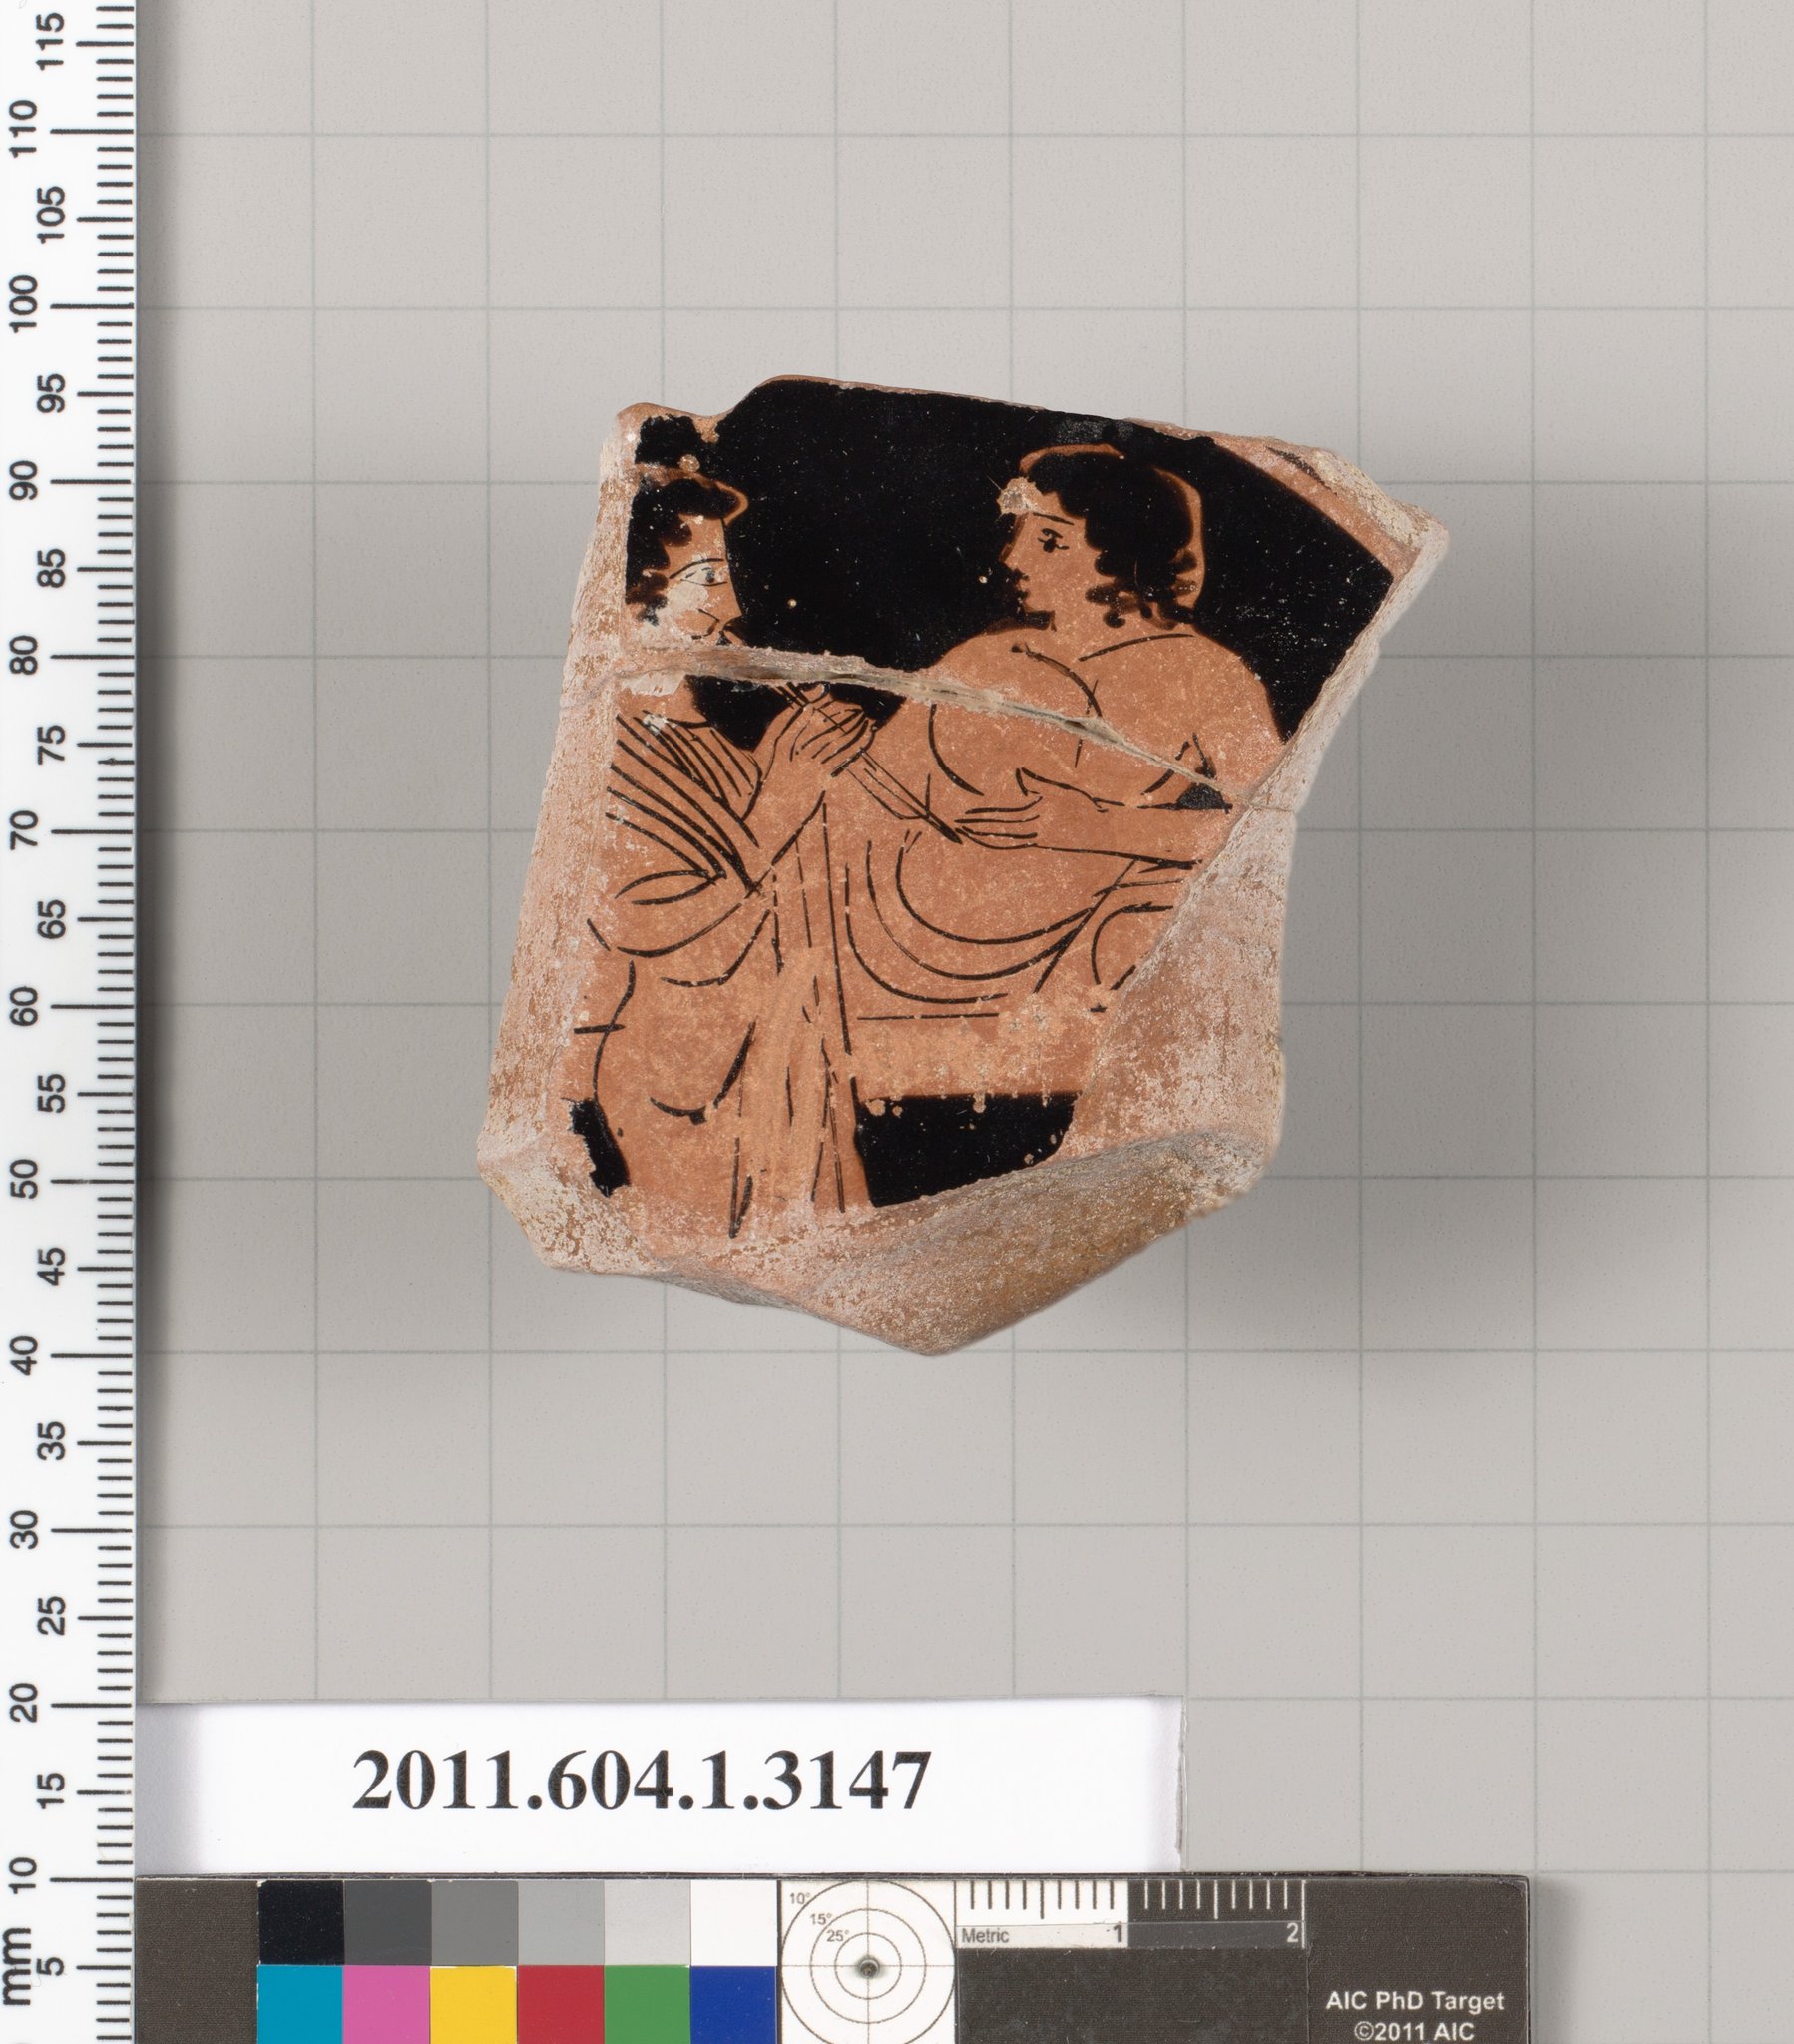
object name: kylix fragment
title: Terracotta fragment of a kylix (drinking cup)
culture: greek, attic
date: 460-450 BCE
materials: terracotta